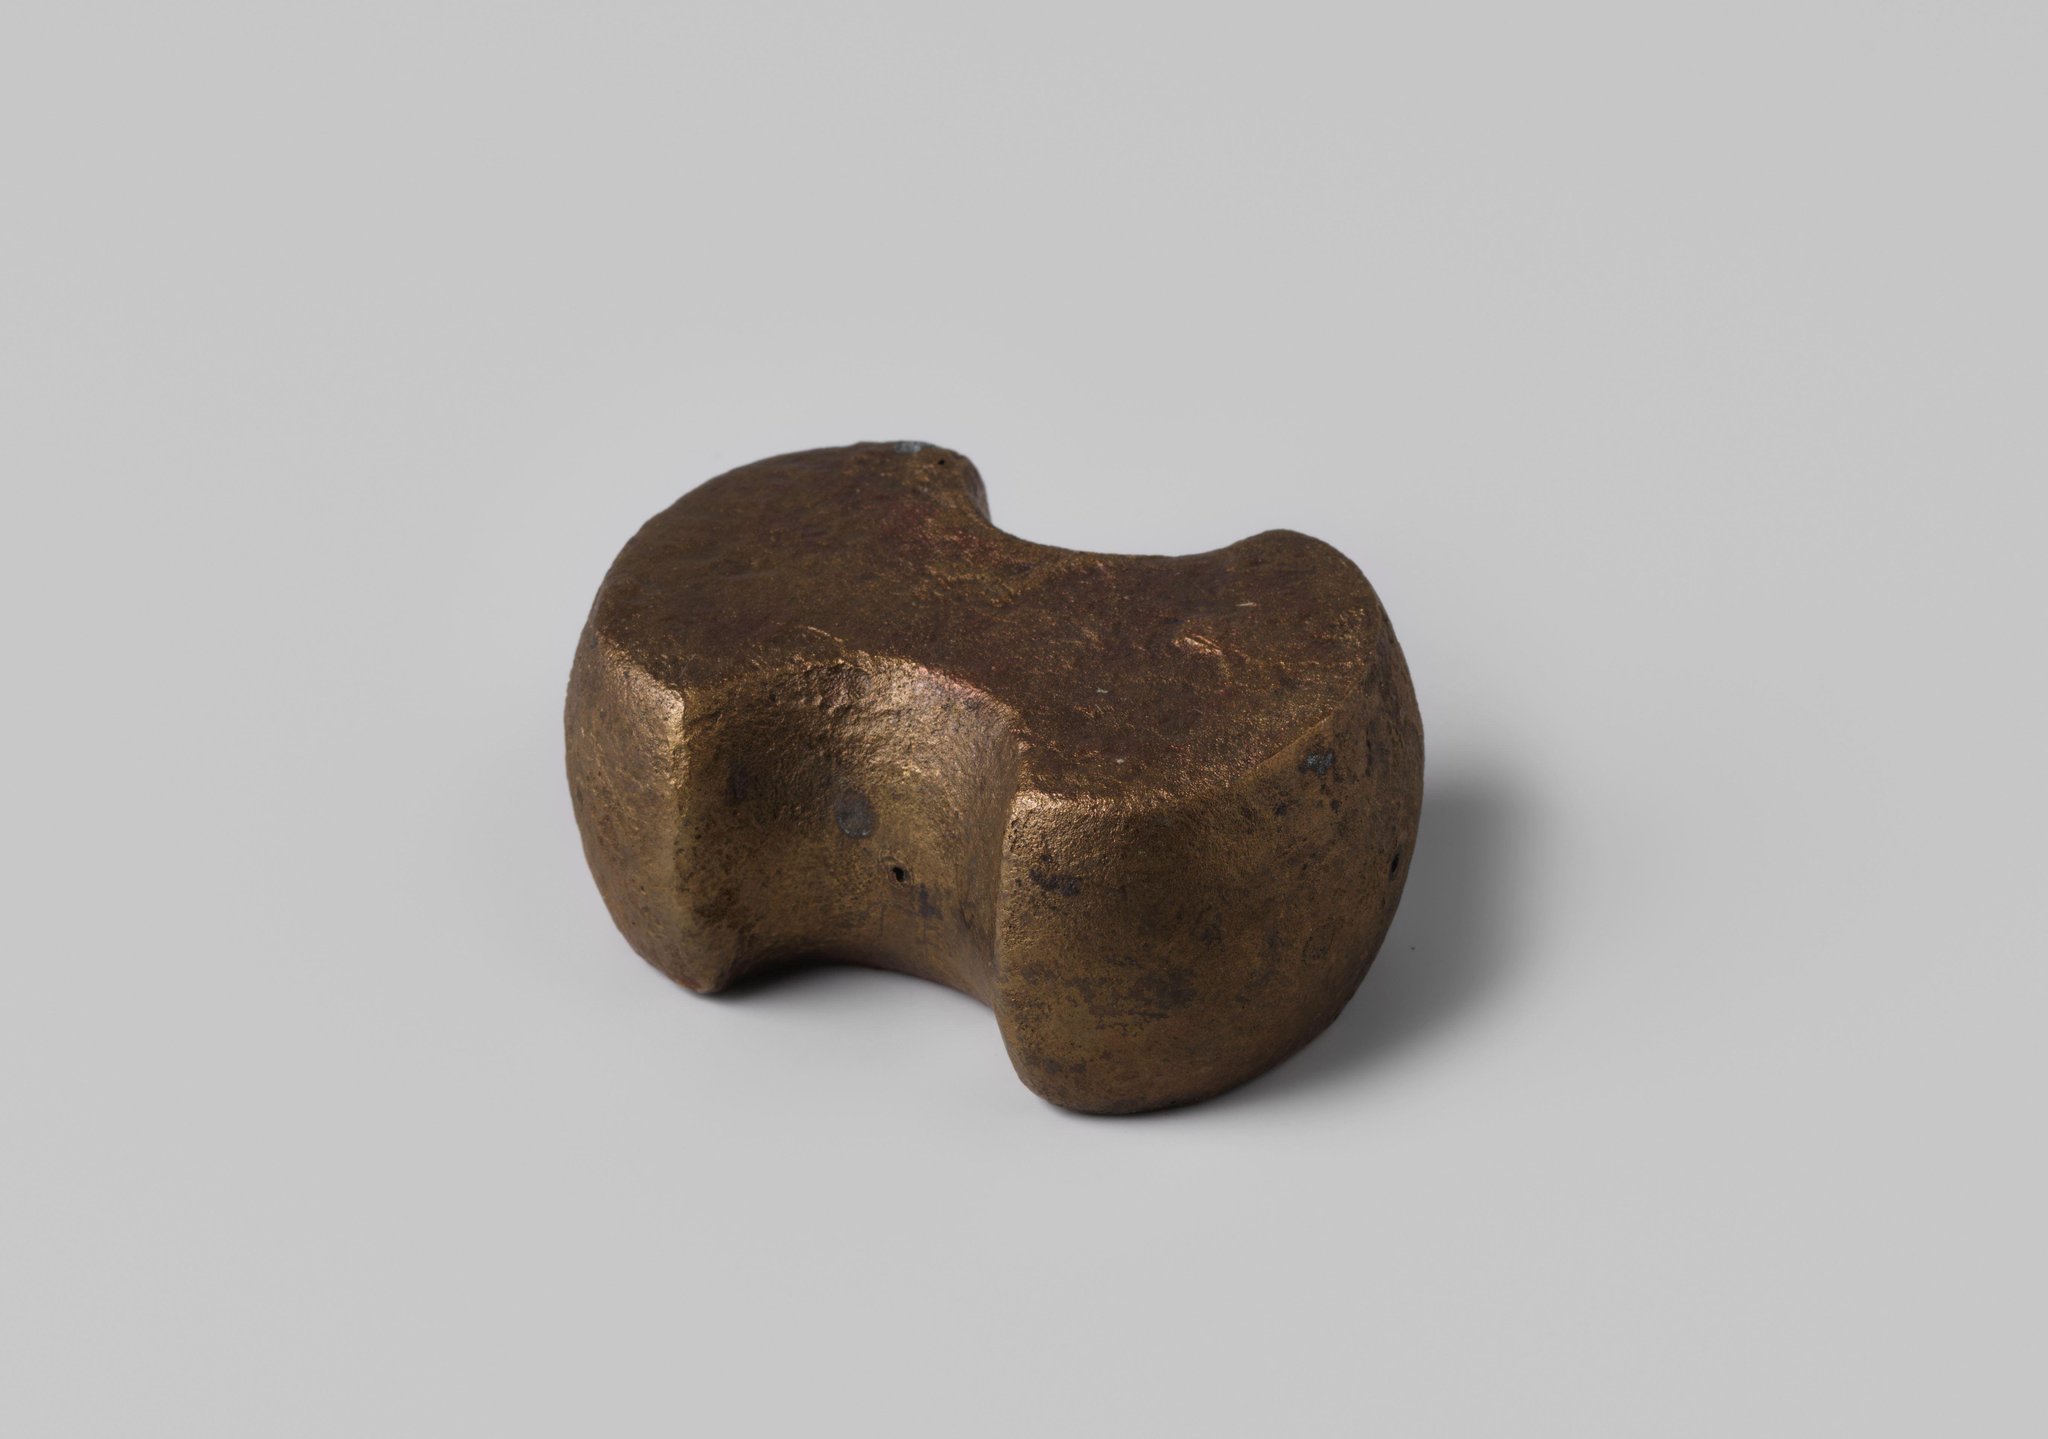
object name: weight scale component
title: Violin-shaped Chinese tael weight from the wreck of the Dutch East India ship 't Vliegend Hart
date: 1700-1735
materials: copper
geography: china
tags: 't vliegend hart (schip), ming li-foo, verenigde oostindische compagnie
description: Koperen tael- of qiangewicht met Chinese en Europese inscripties waarmee goud en andere kostbaarheden werden gewogen. vioolgewicht, violin-shaped weights